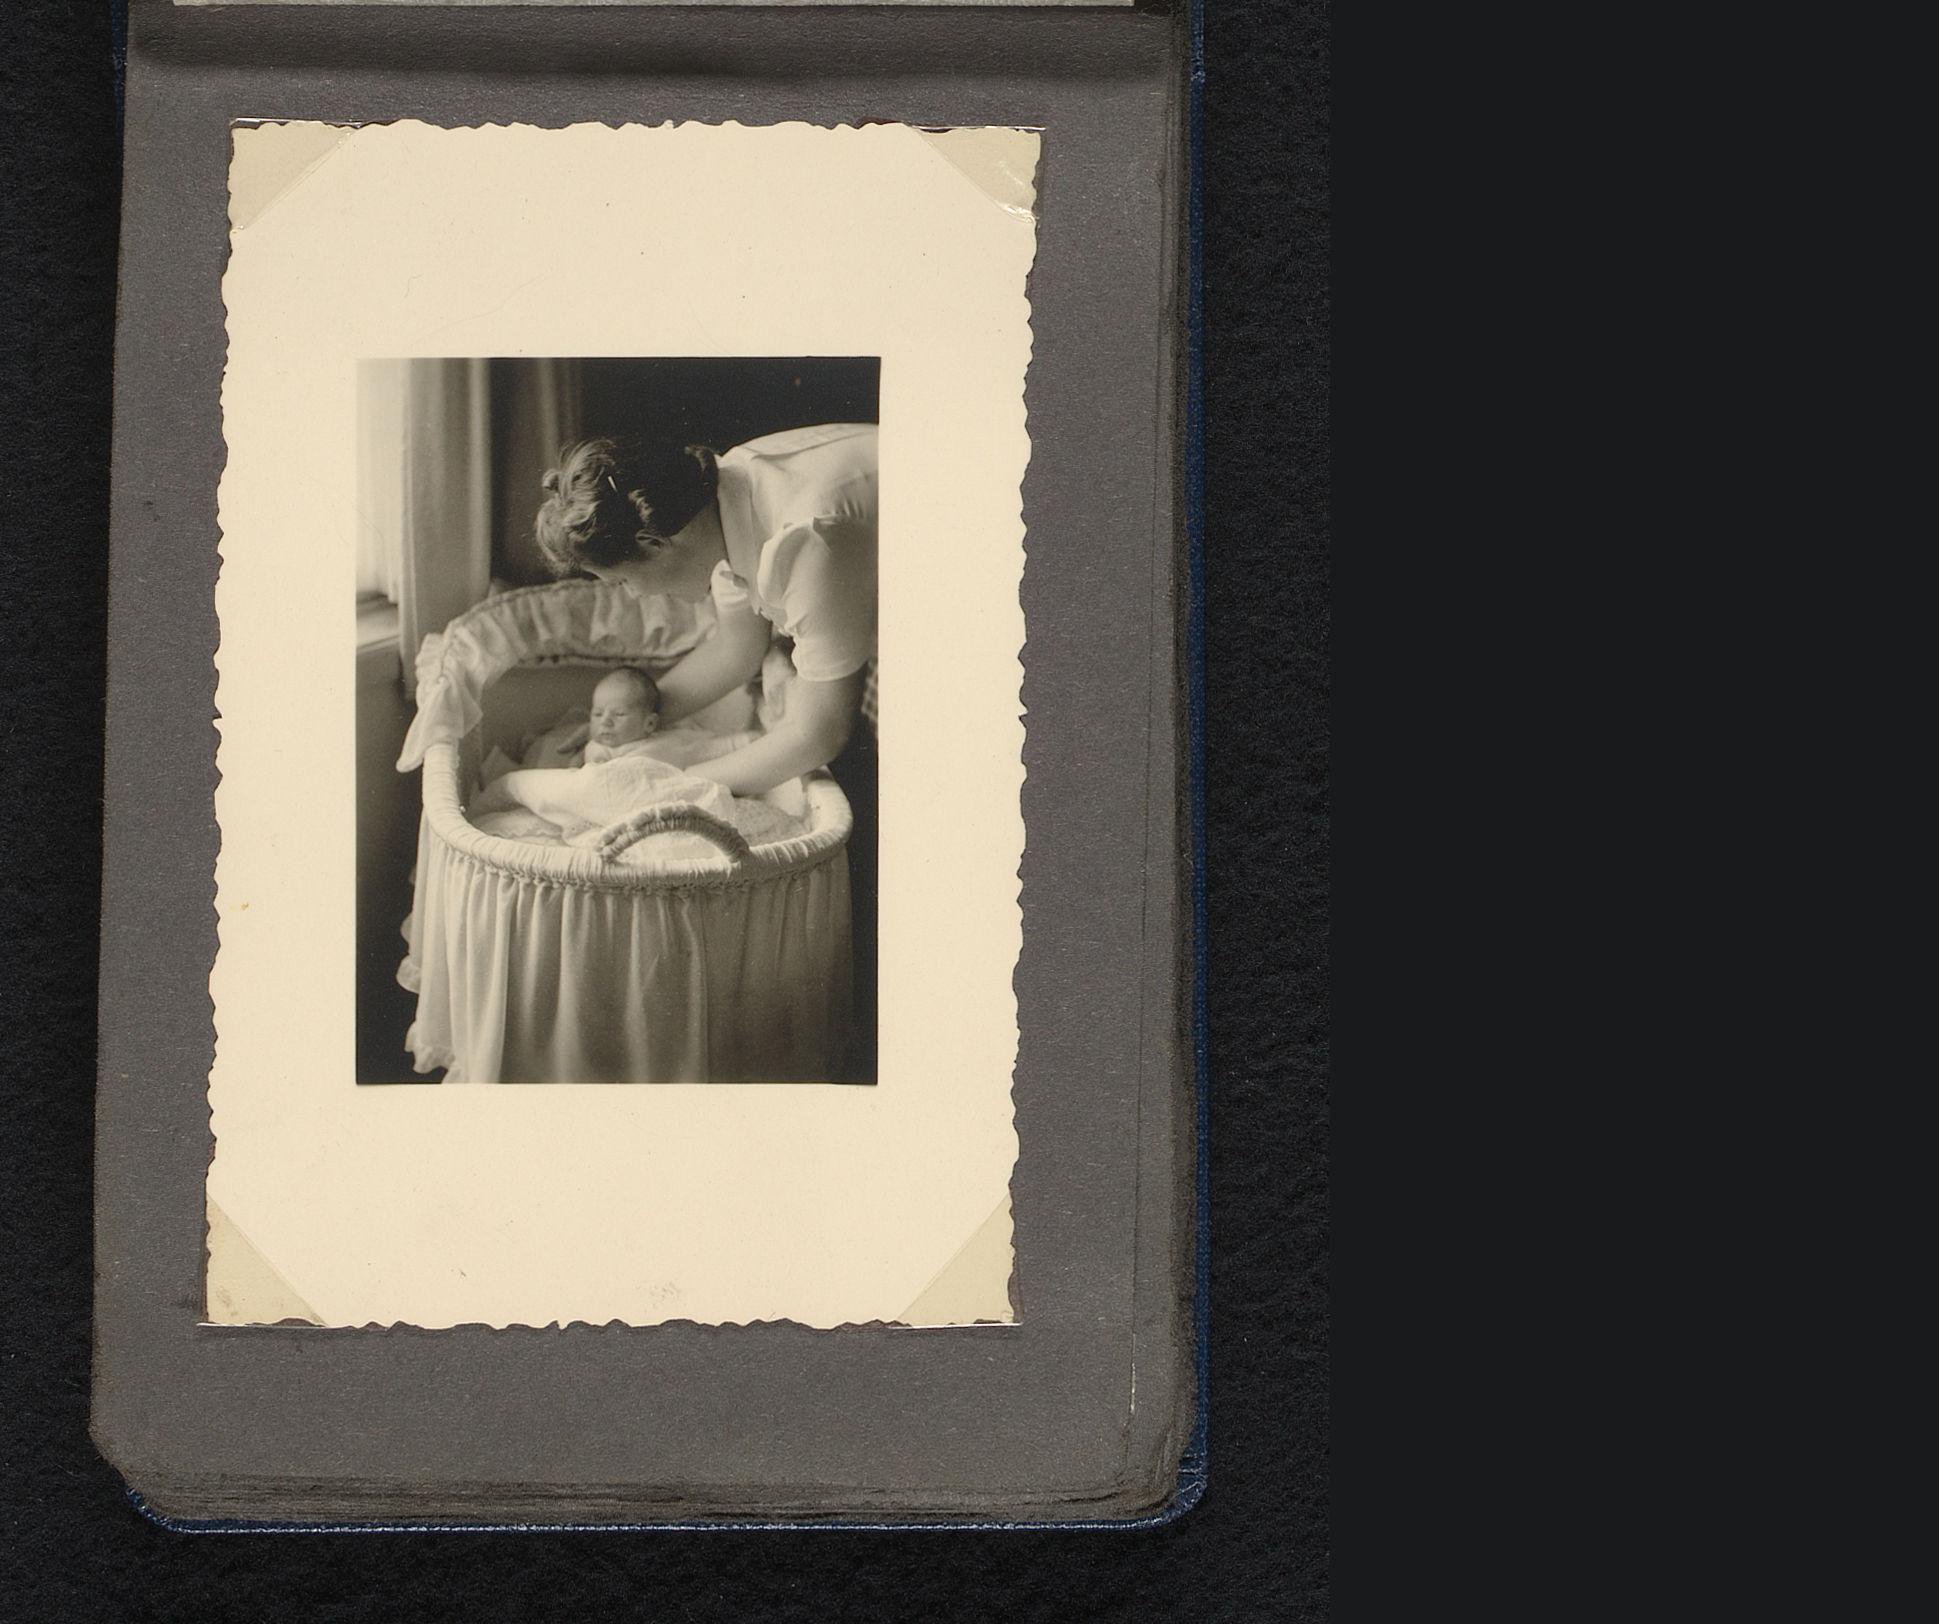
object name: photograph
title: Maria Louise van den Berg-Halbertsma bij zoon Norbert als pasgeboren baby in een wieg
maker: norbert peter van den berg (1941-)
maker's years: 1941-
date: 1941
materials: paper, cardboard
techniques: gelatin silver print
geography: netherlands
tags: norbert peter van den berg (1941-), rotterdam, maria louise van den berg-halbertsma, adult woman, cradle, crib, infant, baby